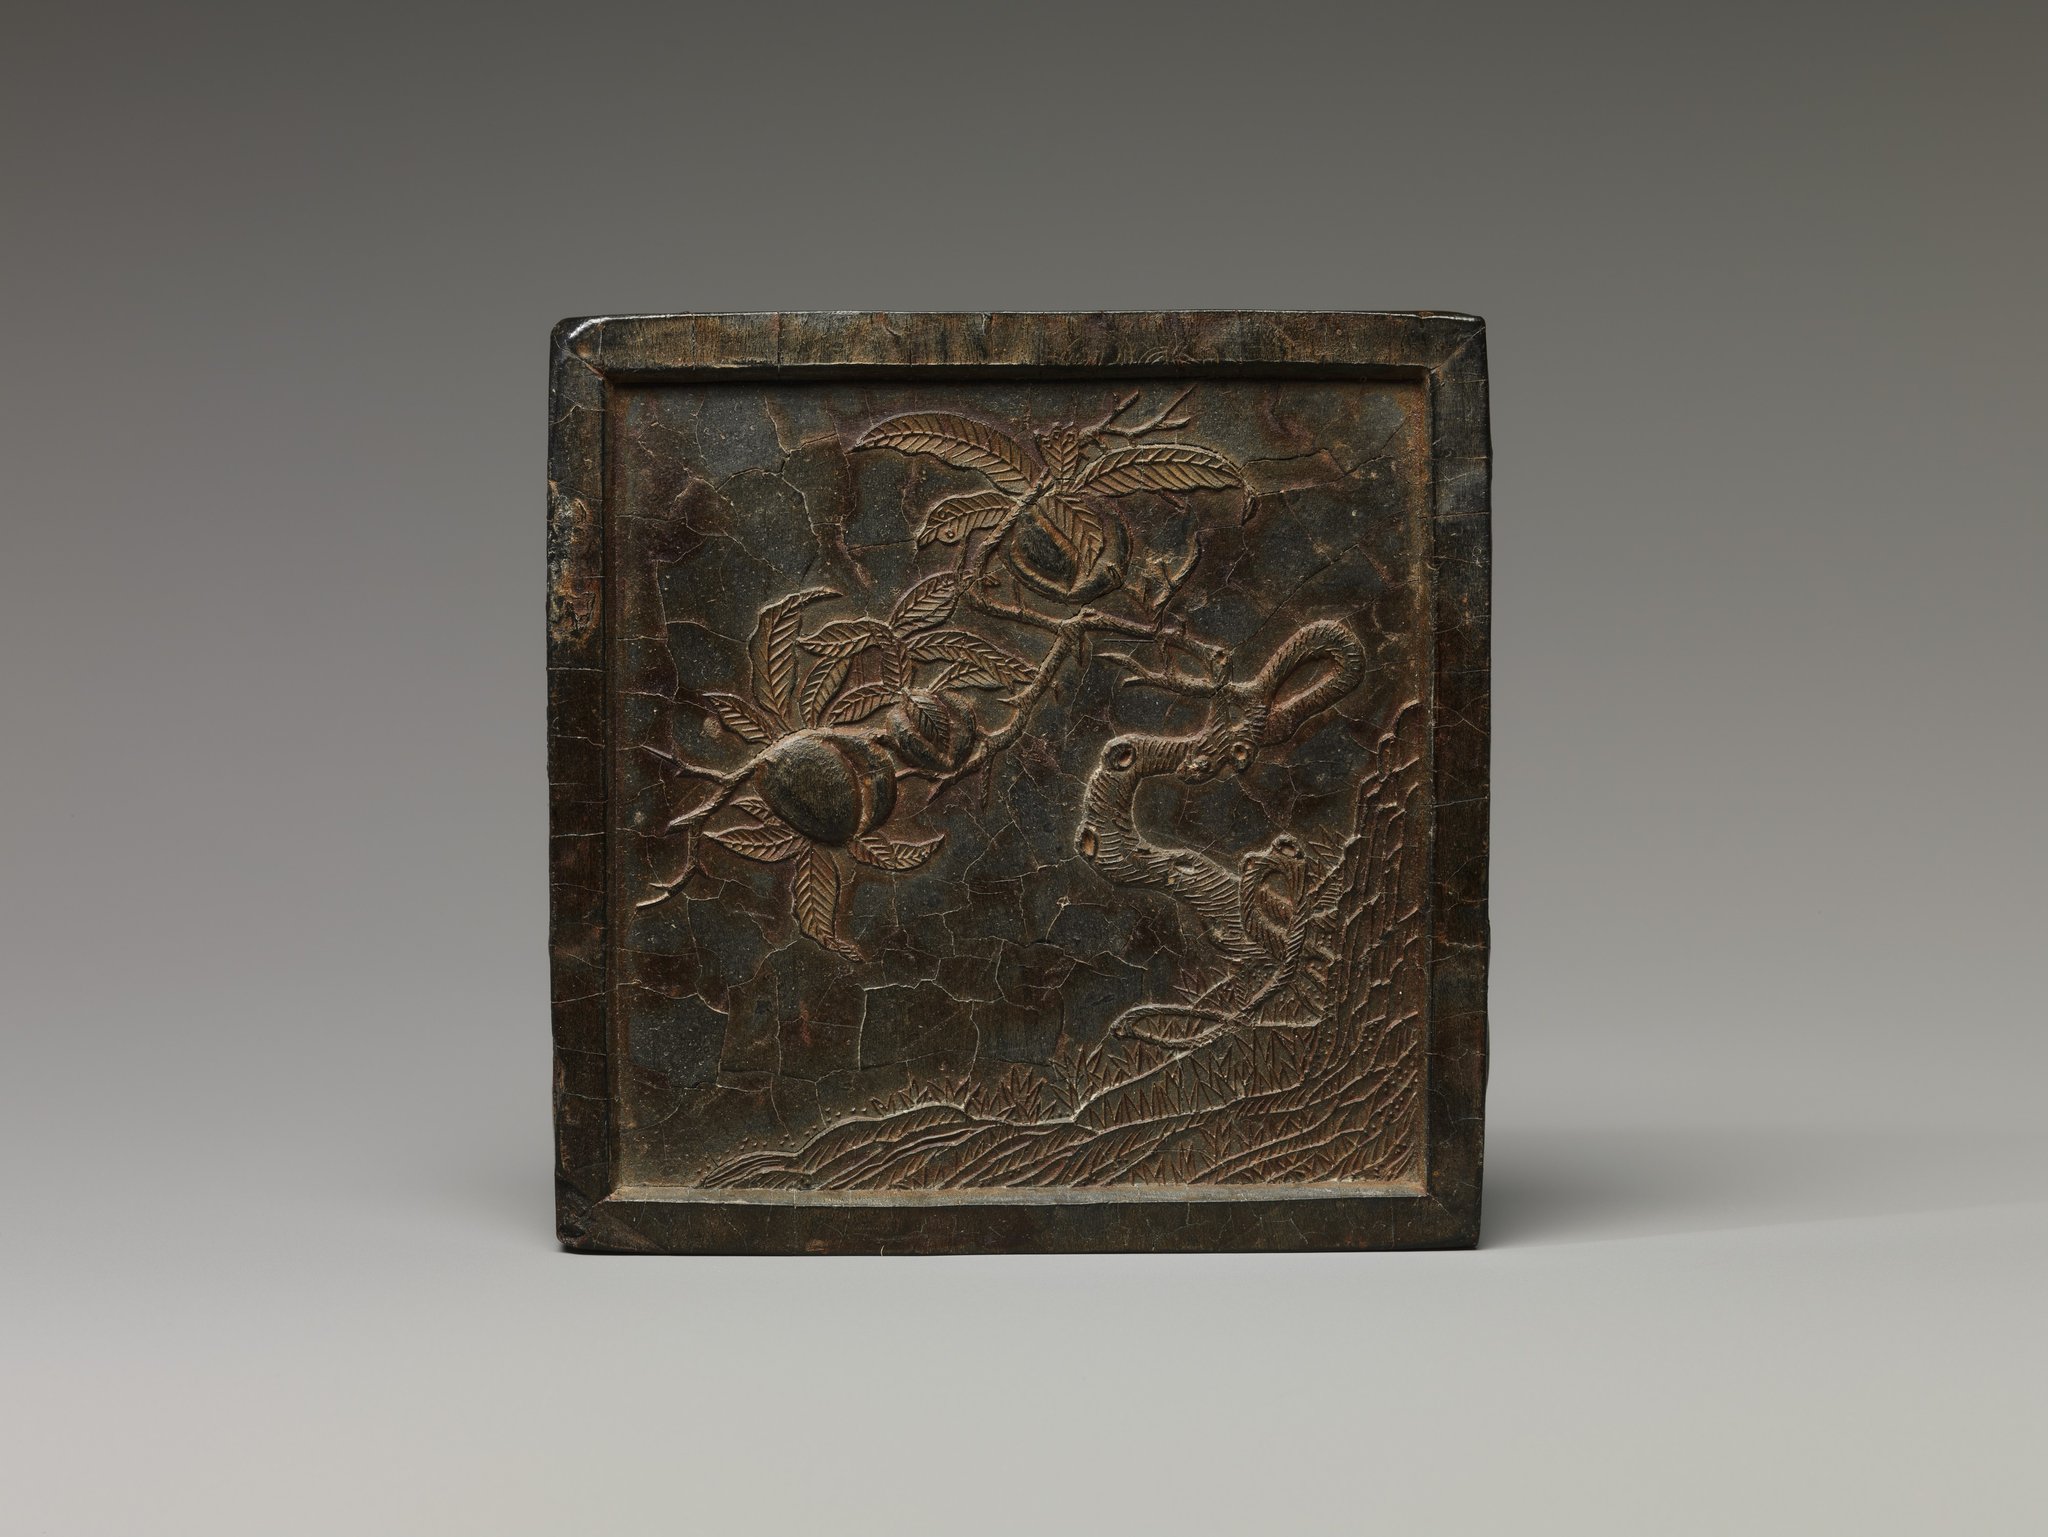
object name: ink tablet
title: Ink Tablet with Peach Tree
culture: chinese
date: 1867-1933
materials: ink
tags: peaches,trees